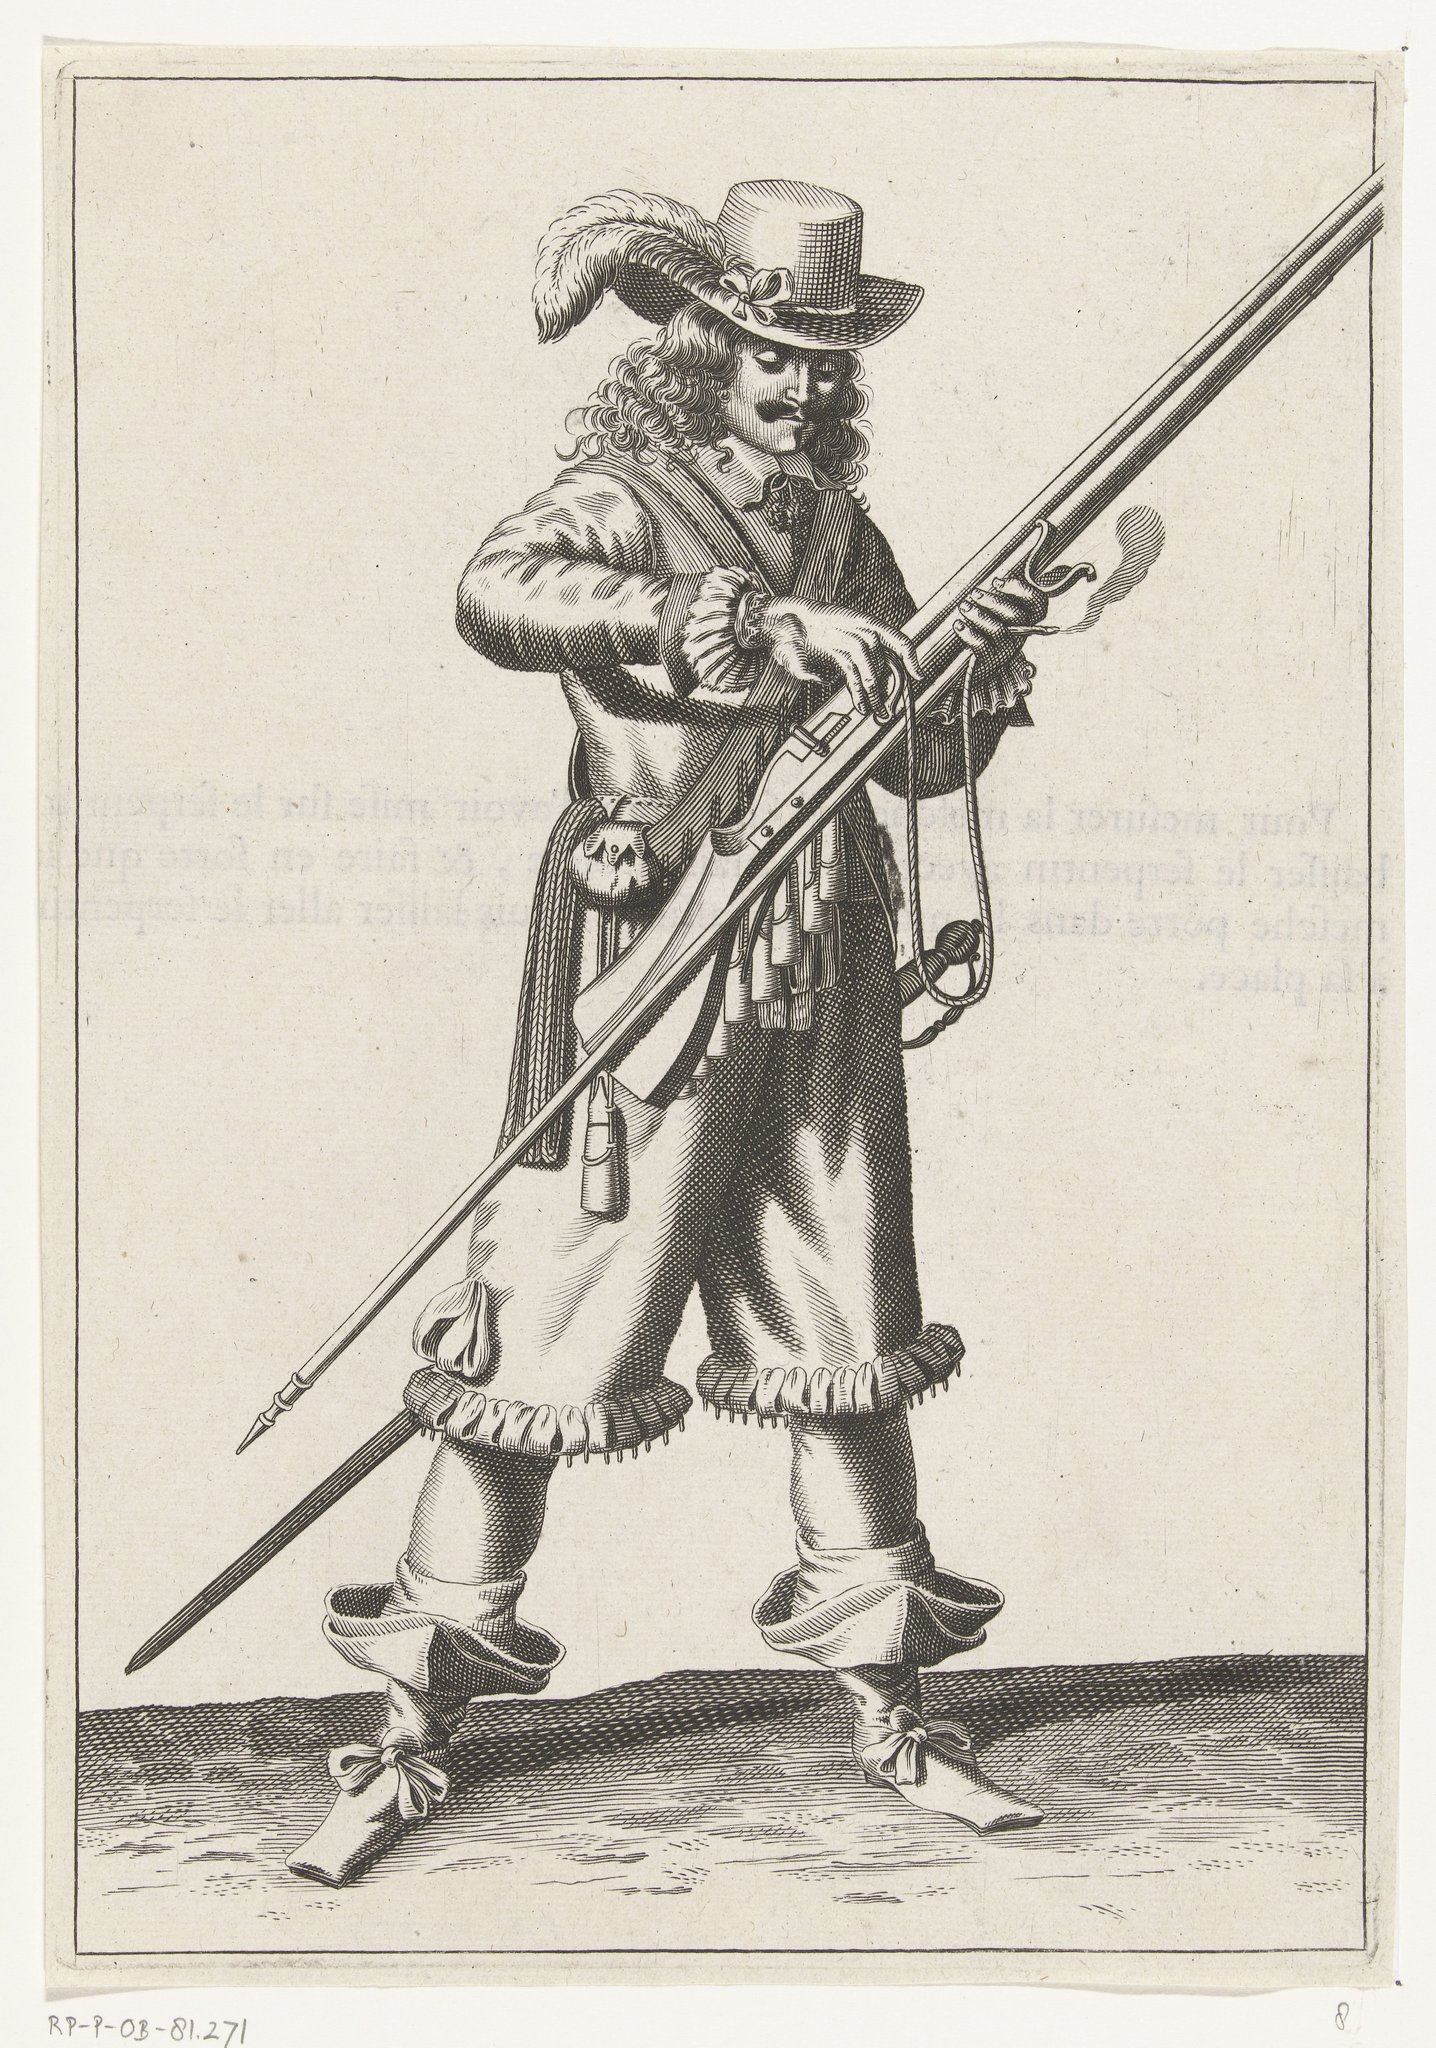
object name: print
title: Soldaat die zijn lont van de haan van zijn musket losmaakt, ca. 1645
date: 1645-1647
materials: paper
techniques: engraving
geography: southern netherlands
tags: handling of weapons ~ military training, weapons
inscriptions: annotation: ‘Mettez la mesche sur le serpetnue blz 19’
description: Een soldaat, ten voeten uit, naar rechts, die een musket (een bepaald type vuurwapen) en een furket (musketvork) met zijn linkerhand vasthoudt. Met zijn rechterhand maakt hij de brandende lont los die op de haan (onderdeel van het ontstekingsmechanisme) van zijn musket ligt, ca. 1645. Bedrukt op achterzijde met tekst in het Frans. Vrij naar plaat 14 in de instructies voor het hanteren van het musket in de Wapenhandelinghe van J. de Gheyn. Krijgswezen rond 1600.